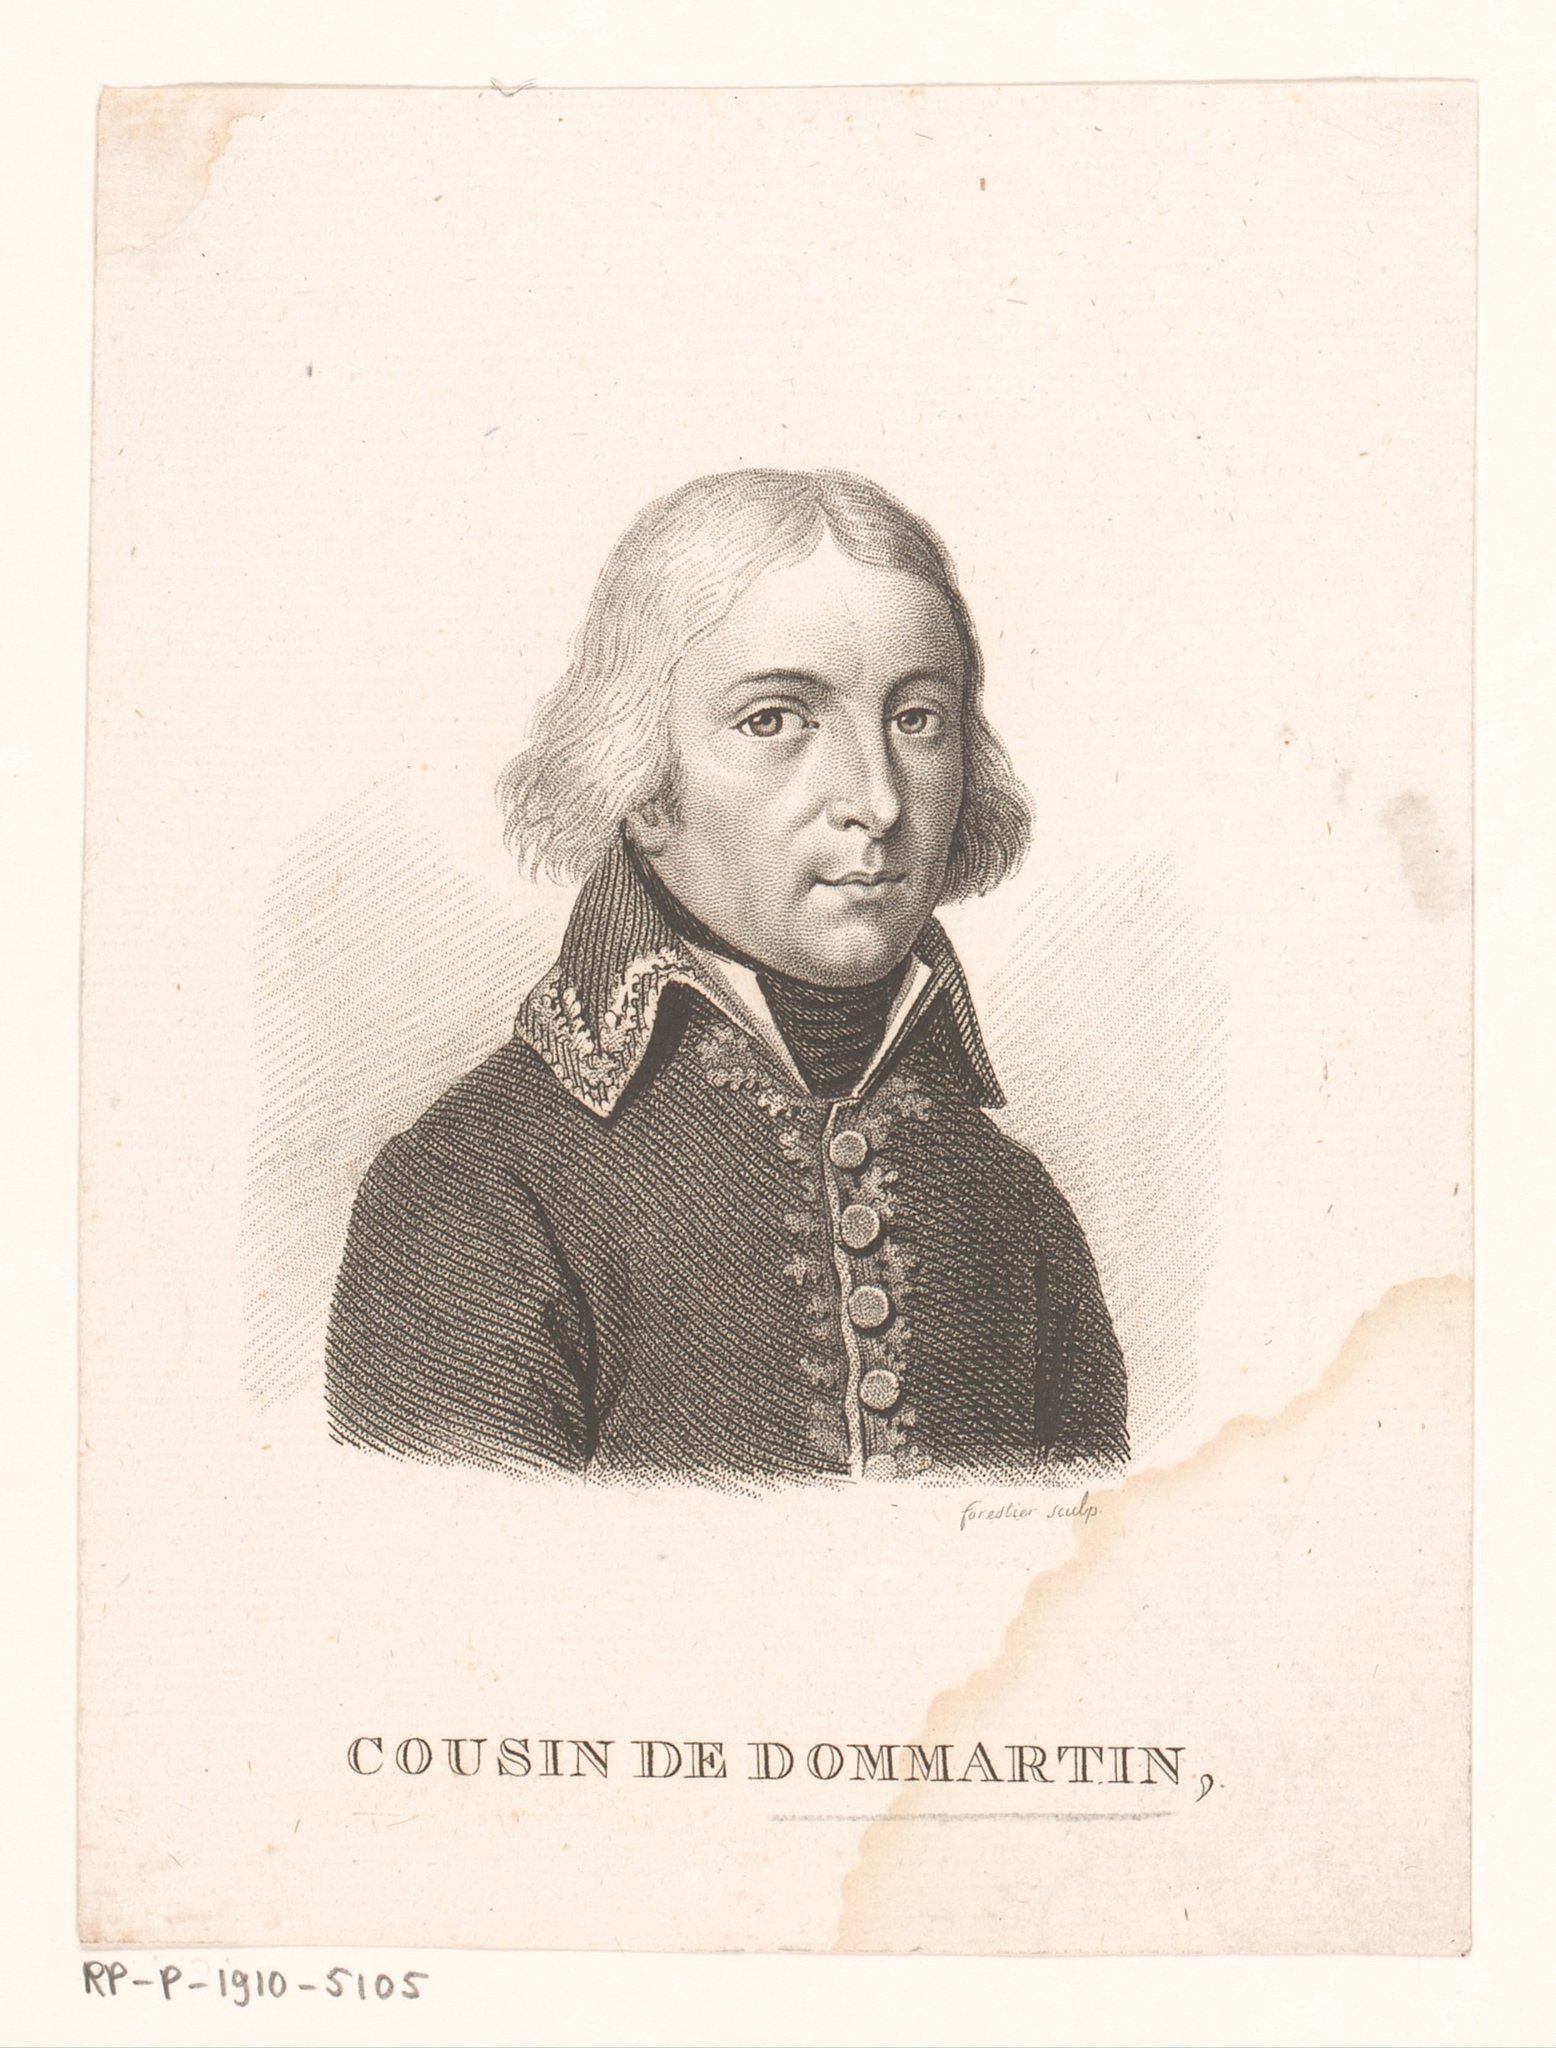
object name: book illustration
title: Portret van Elzéard Auguste Cousin de Dommartin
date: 1818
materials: paper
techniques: etching, roulette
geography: paris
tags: commander-in-chief, general, marshal, historical persons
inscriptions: collector's mark: Lugt 2228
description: Mogelijk prent uit: Tardieu, Ambroise. Portraits des généraux français, faisant suite aux "Victoires et conquêtes des Français". Parijs: Panckoucke, Charles Louis Fleury, ca. 1818.